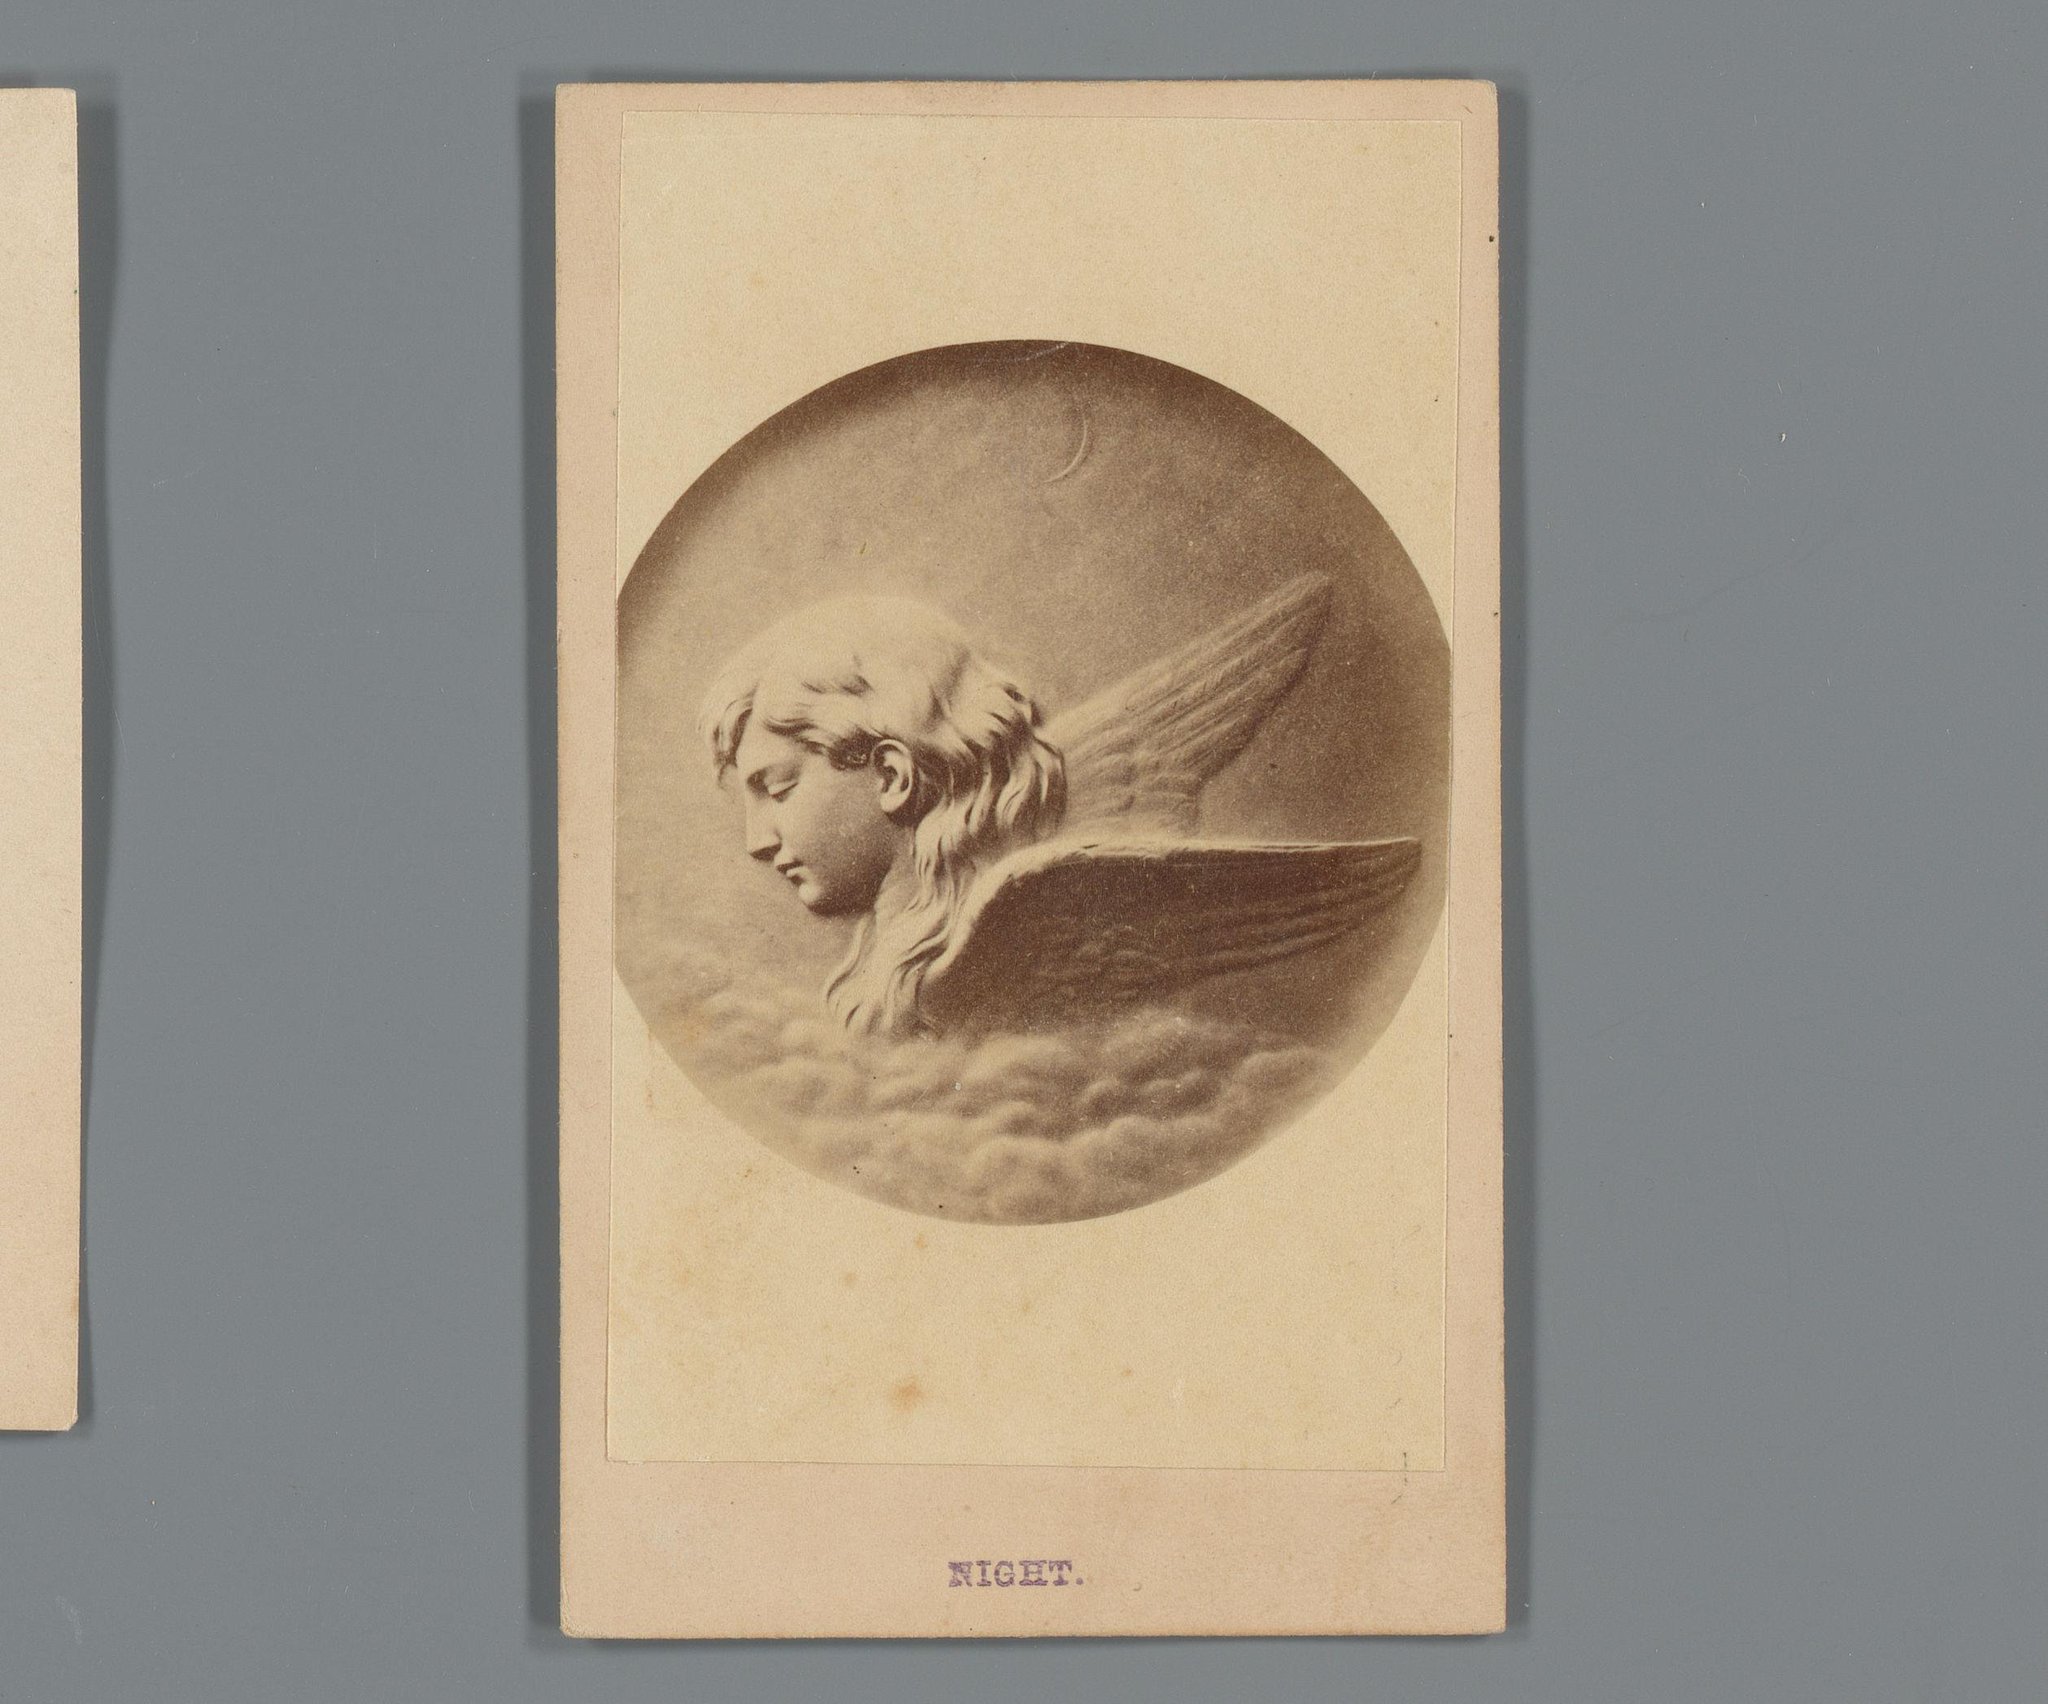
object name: reproduction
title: Fotoreproductie van een reliëf van een engel met reclame voor Photograph Novelty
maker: Anonymous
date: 1850-1915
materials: cardboard, photographic support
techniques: albumen print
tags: cherubs, i.e. children's heads with wings, advertising, decorating 'en relief', appliquéing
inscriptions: inscription: ‘PHOTOGRAPH NOVELTY./ (...)’